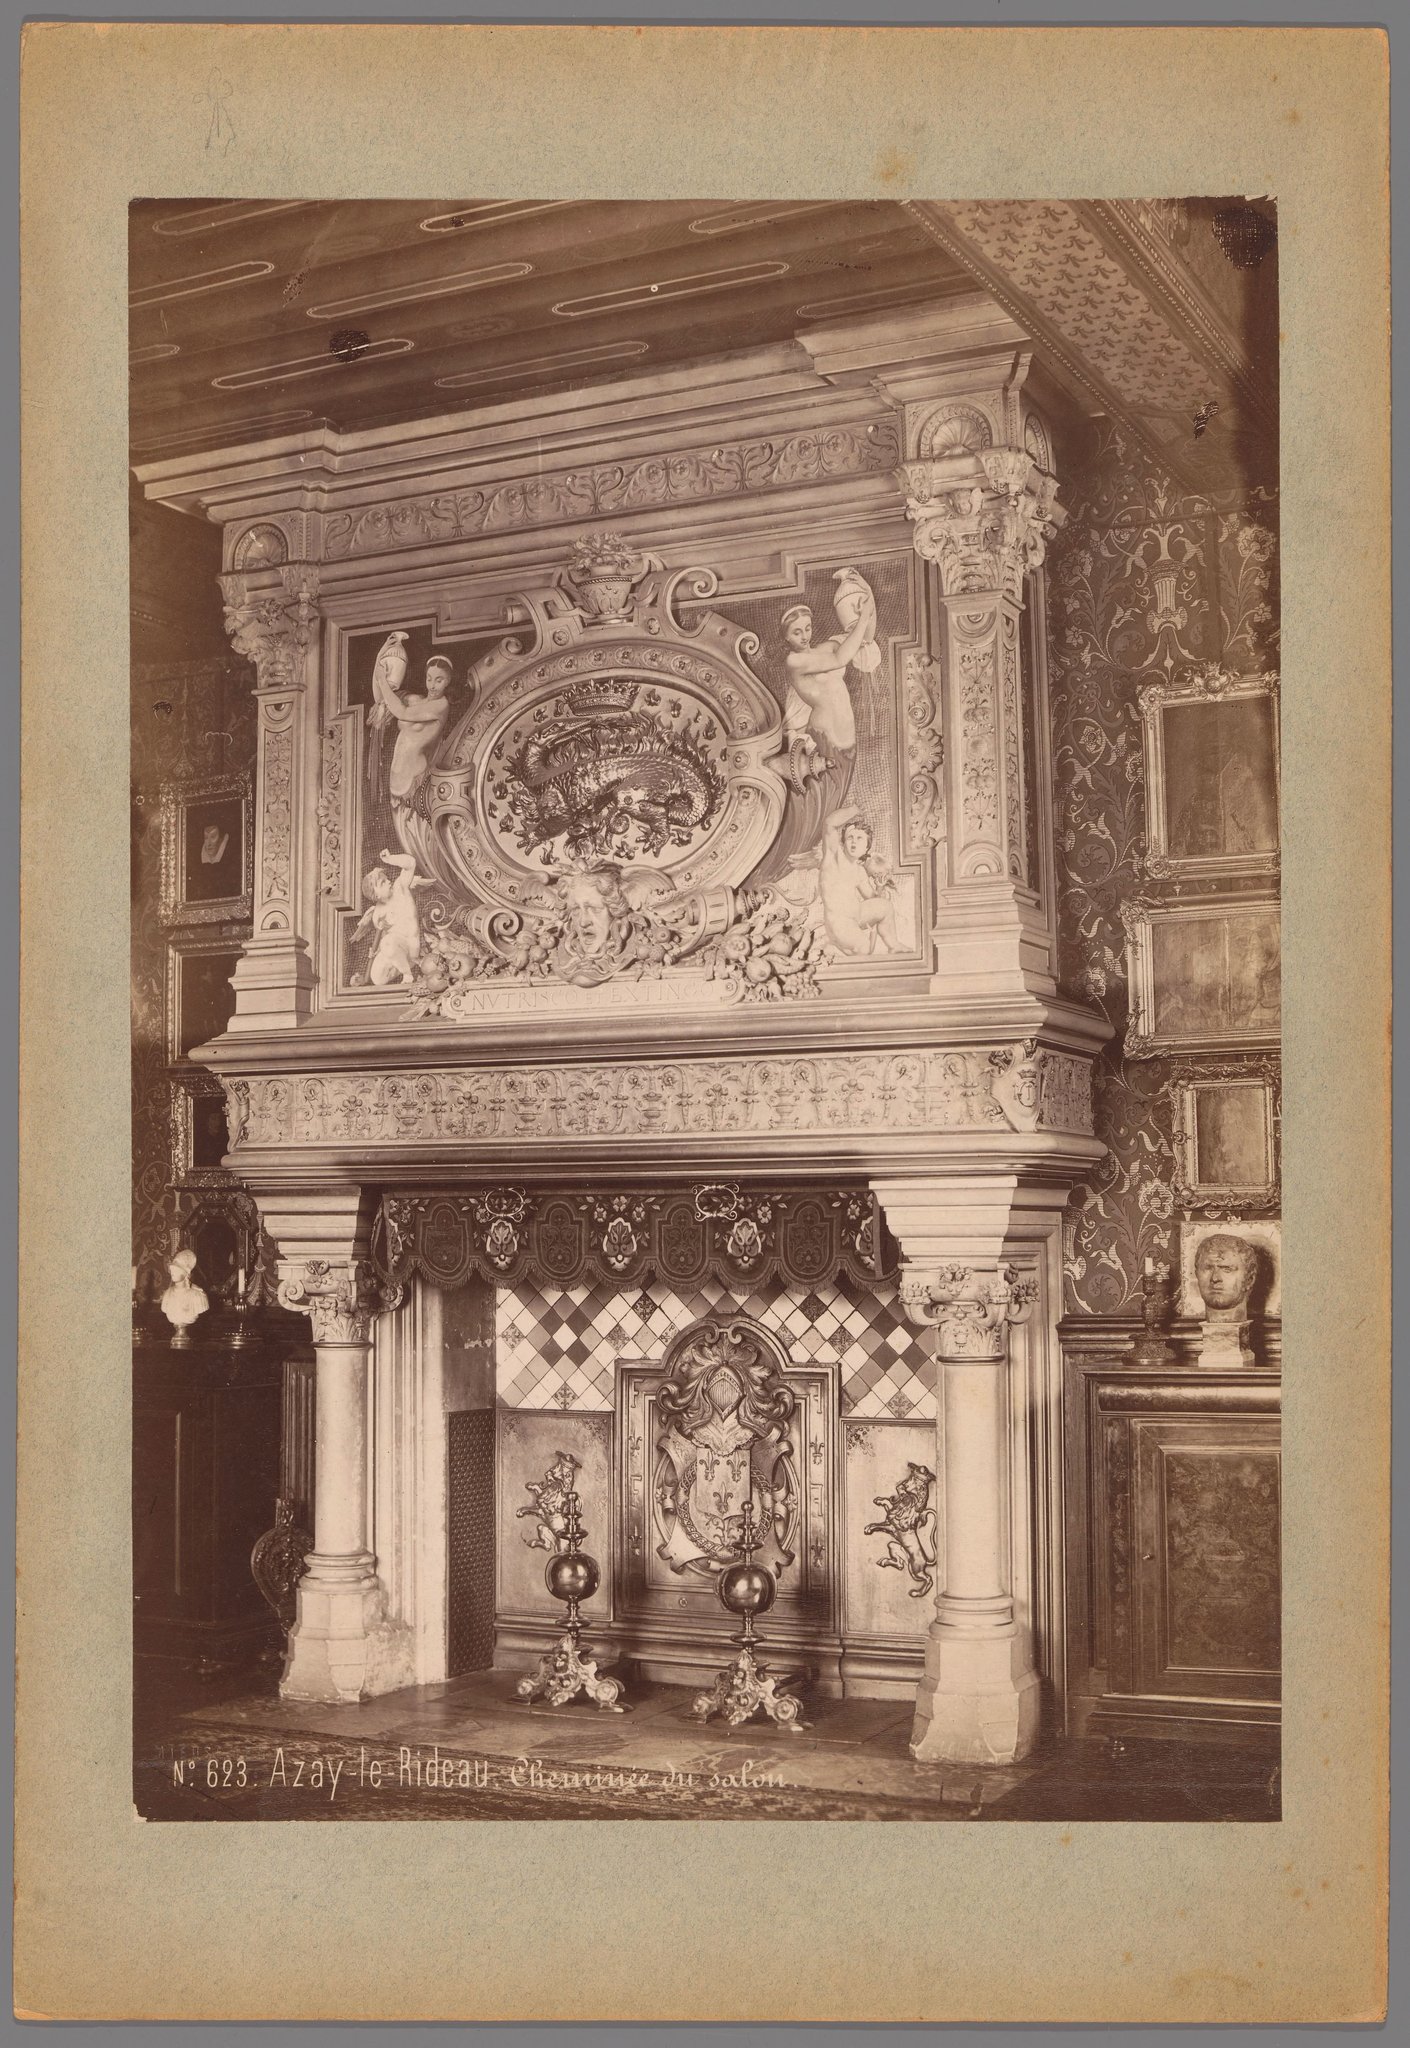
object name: photograph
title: Azay-le-Rideau, Cheminée du salon.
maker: séraphin-médéric mieusement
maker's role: fotograaf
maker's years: 1840-1905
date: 1875-1900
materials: cardboard, photographic support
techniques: albumen print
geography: château d'azay-le-rideau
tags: drawing-room, 'salon', castle, open hearth, fire-place, interior ~ representation of a building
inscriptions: number: ‘No. 623.’, name: ‘MIEUSEMENT PHOTOGRAPHE’, name: ‘KUNSTBOEKHANDEL J. A. G. DE LEUR PHOTOGRAAF - UITGEVER HUIGENSPARK, 40b. DEN HAAG.’, collector's mark: Lugt 3937, inscription: ‘MONUMENTS HISTORIQUES’